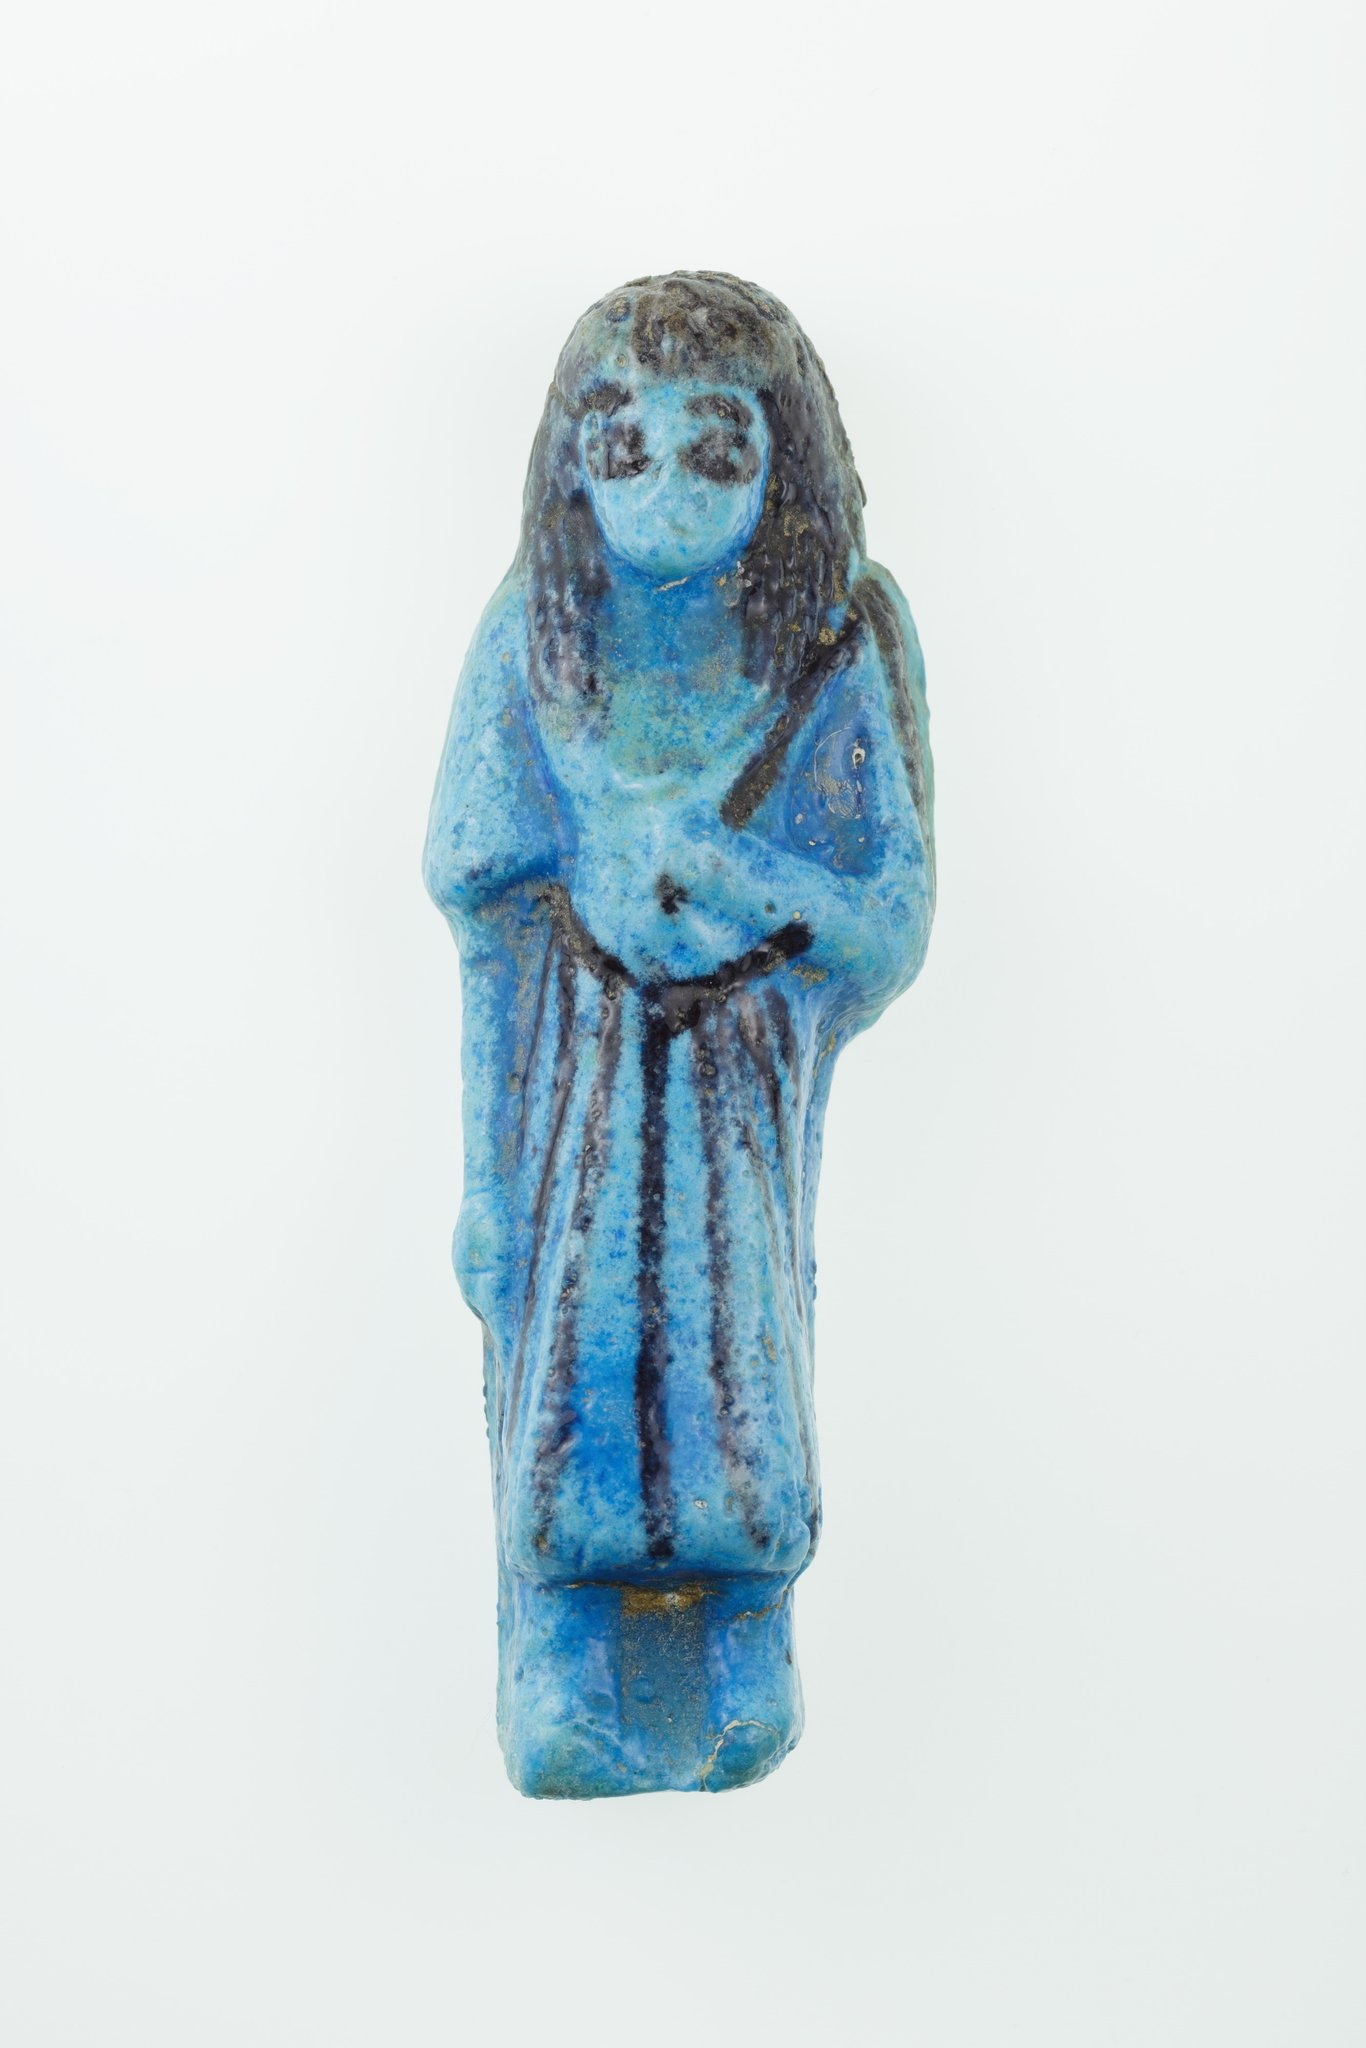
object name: shabti, overseer, nauny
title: Overseer Shabti of Nauny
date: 1050 BCE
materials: faience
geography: egypt